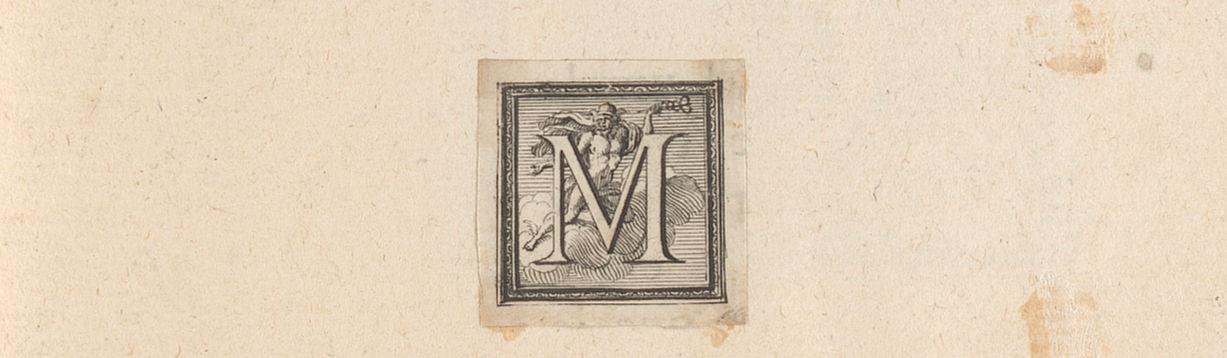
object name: print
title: Initiaal 'M' met Mercurius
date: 1669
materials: paper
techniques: etching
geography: paris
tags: (story of) mercury (hermes), initial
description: Prent uit: Le Laboureur, Louis. La Promenade de Saint-Germain. A Mademoiselle de Scudery. Parijs: Guillaume de Luynes, 1669.